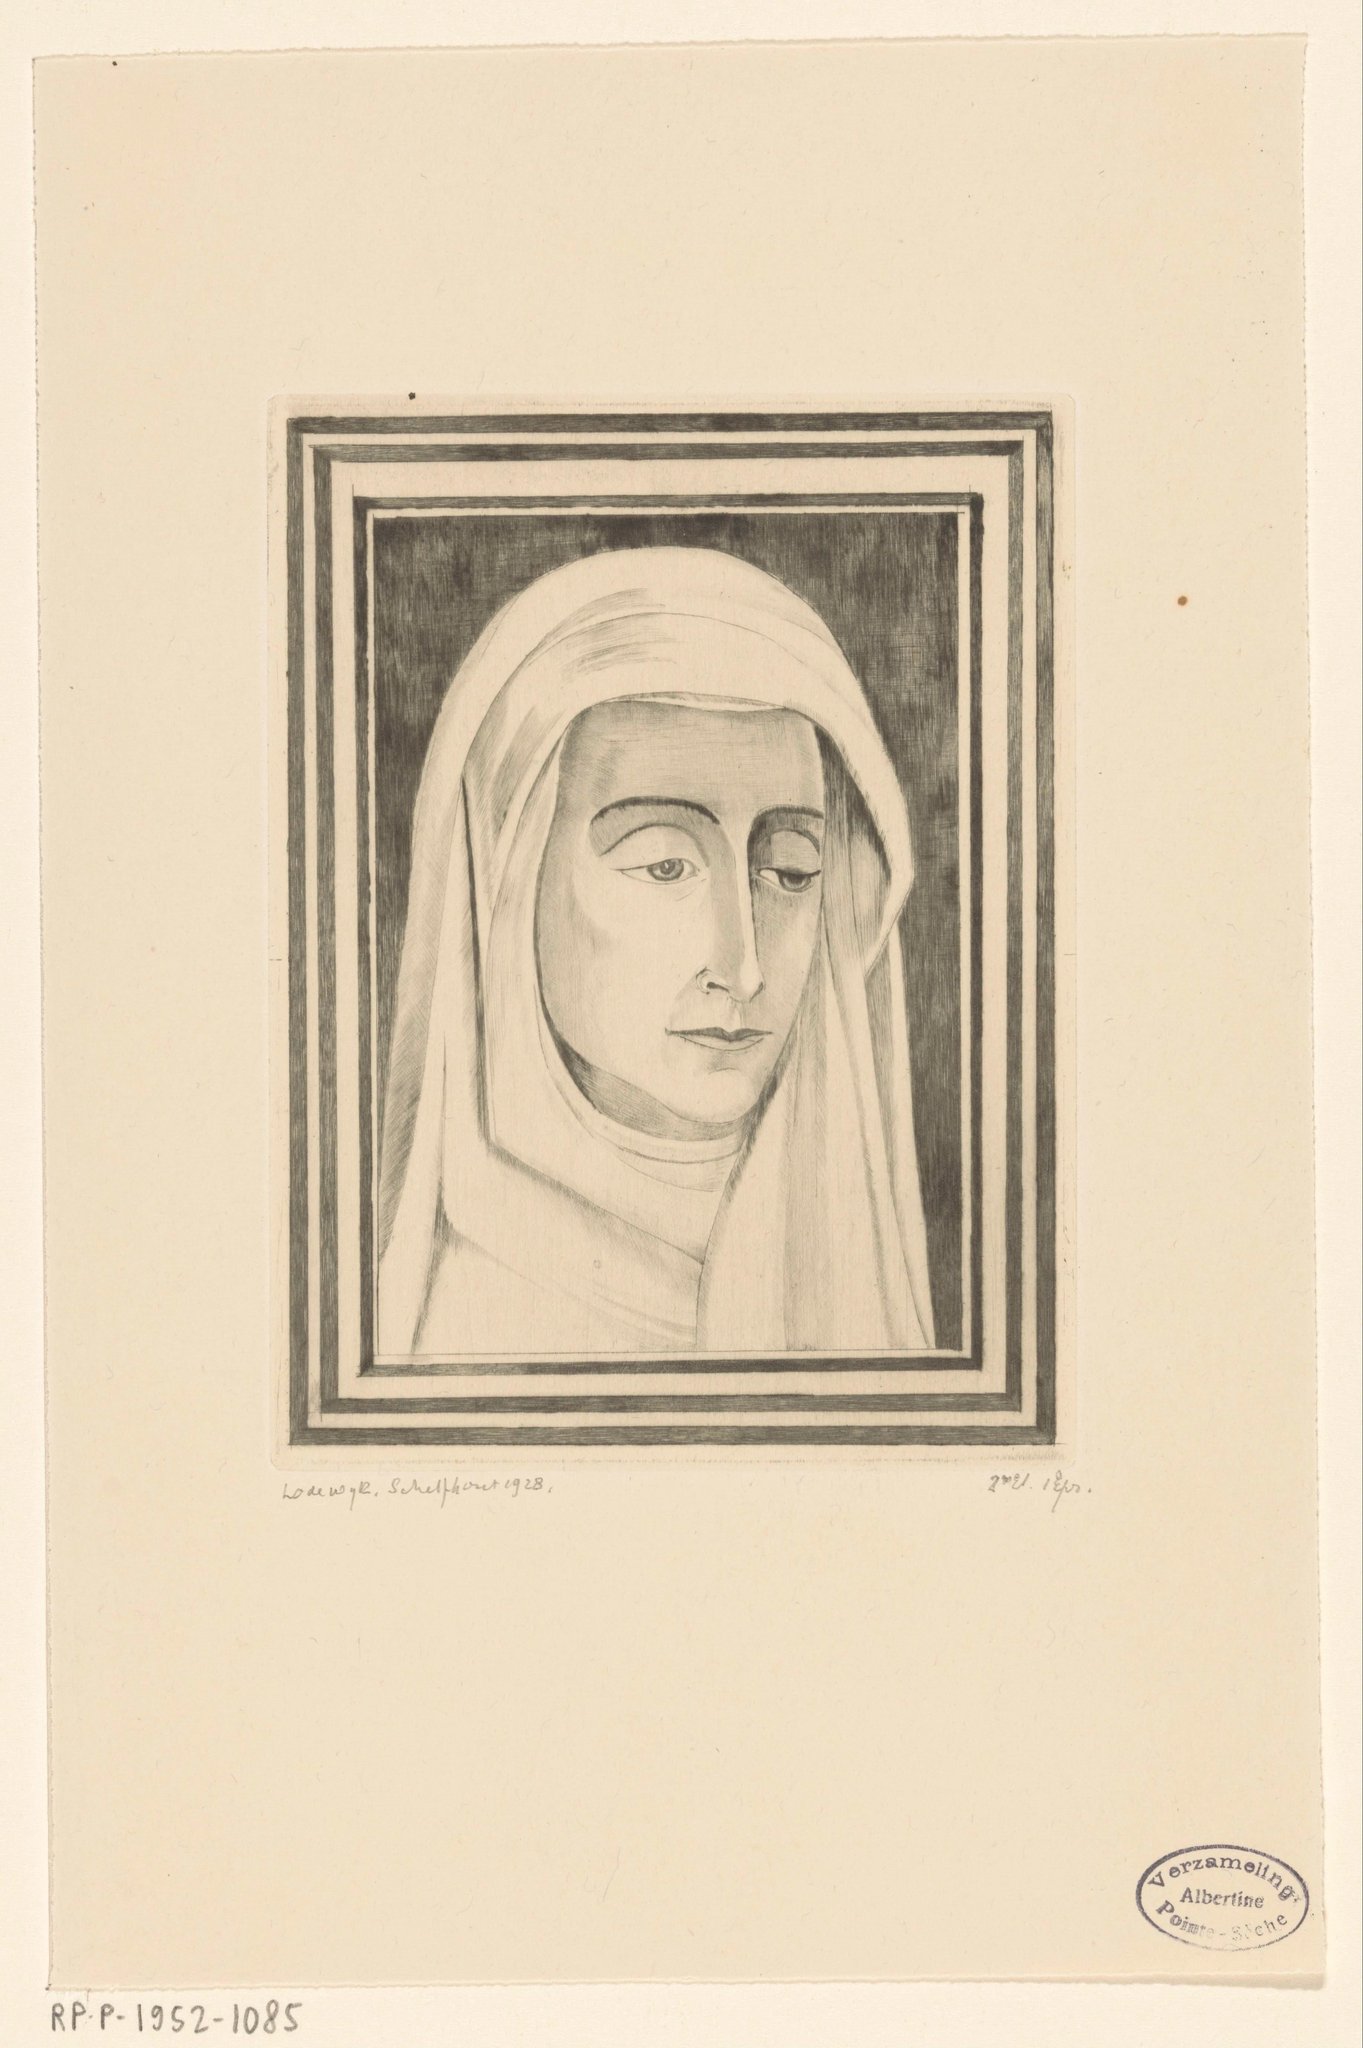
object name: print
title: Tête de femme V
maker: lodewijk schelfhout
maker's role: draughtsman, print maker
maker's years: 1881-1943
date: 1928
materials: paper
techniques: drypoint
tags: veil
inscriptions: collector's mark: Lugt 5i, collector's mark: Lugt 2228